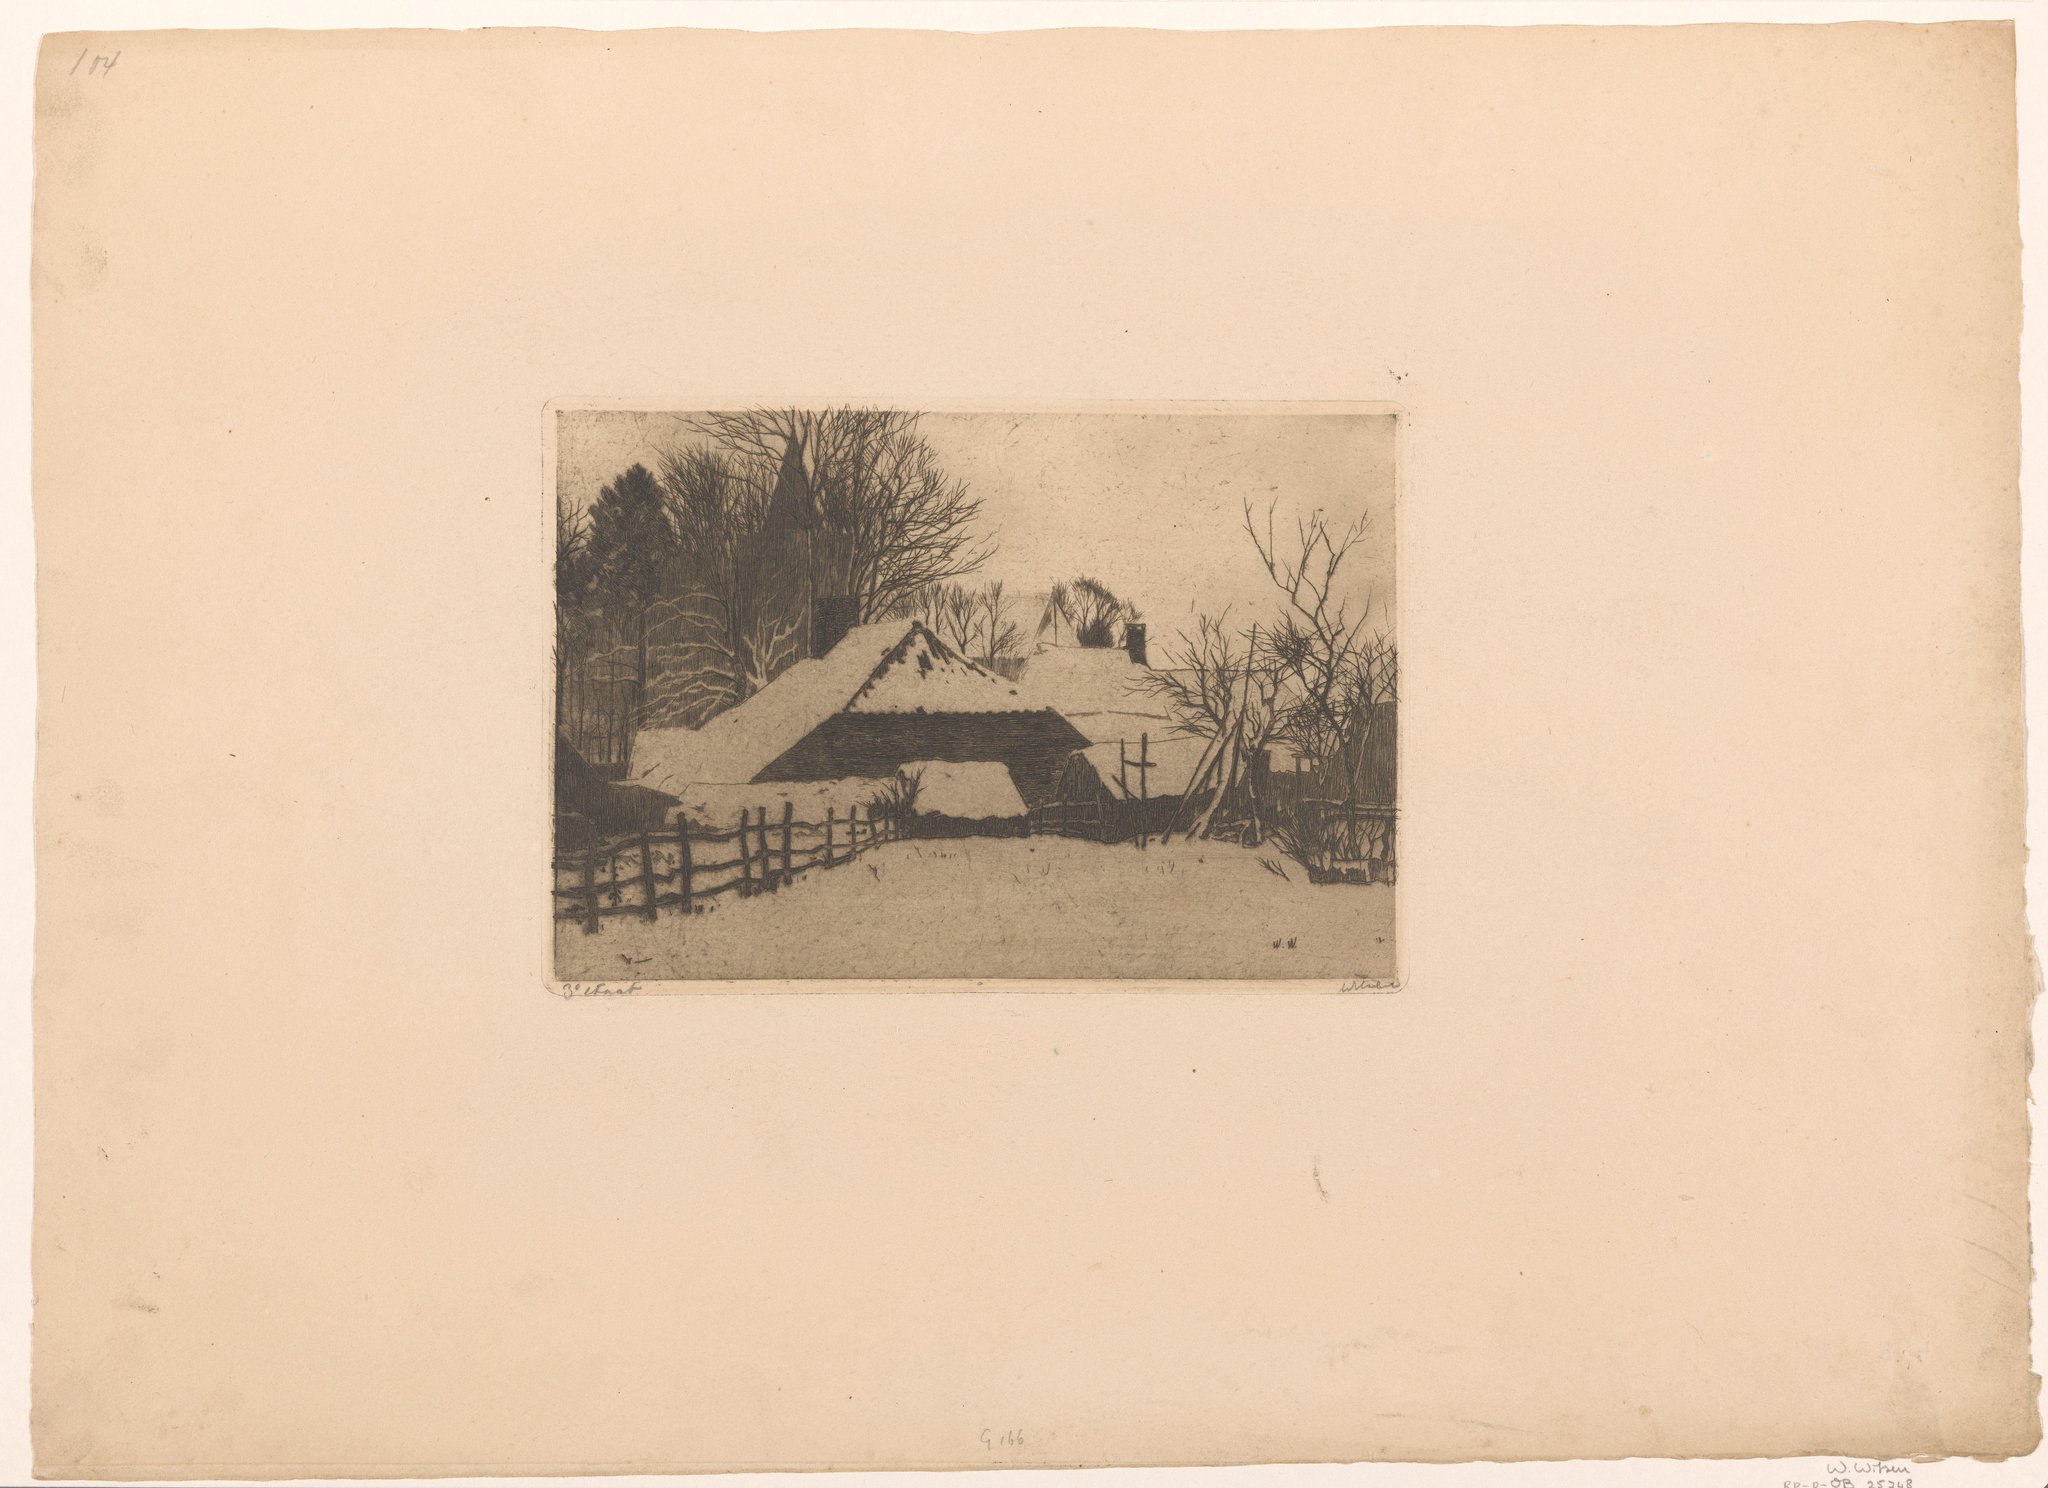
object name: print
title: Gezicht op besneeuwde huizen in Ede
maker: willem witsen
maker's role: draughtsman, painter, print maker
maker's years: 1860-1923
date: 1897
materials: paper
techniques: etching, intaglio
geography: ede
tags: village, snow, parts of church exterior and annexes: tower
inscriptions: inscription: ‘3e staat’, collector's mark: Lugt 2228, signature: ‘Witsen’